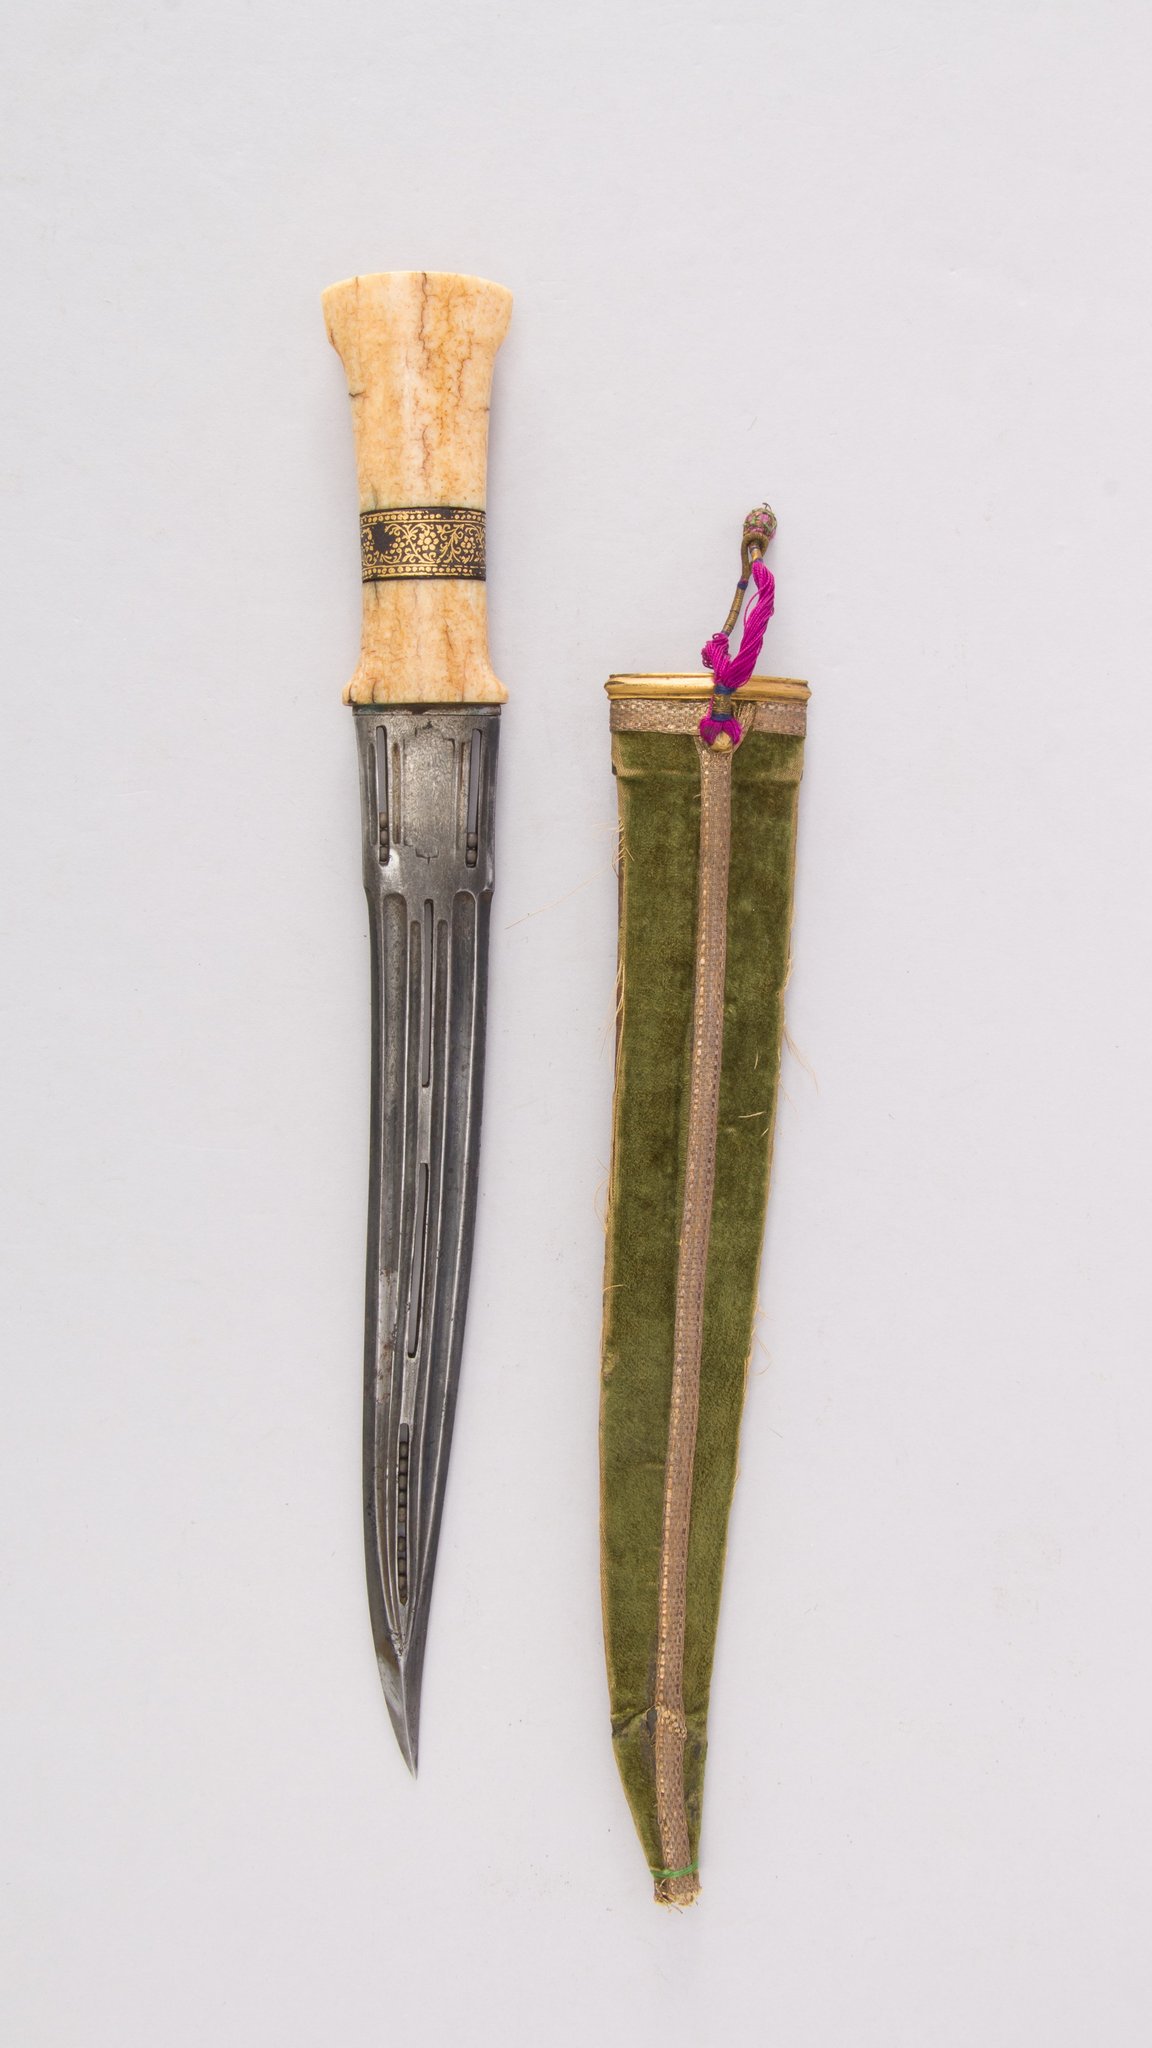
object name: dagger with sheath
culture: indian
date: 1701-1900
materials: copper, gold, ivory, steel, velvet, wood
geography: india